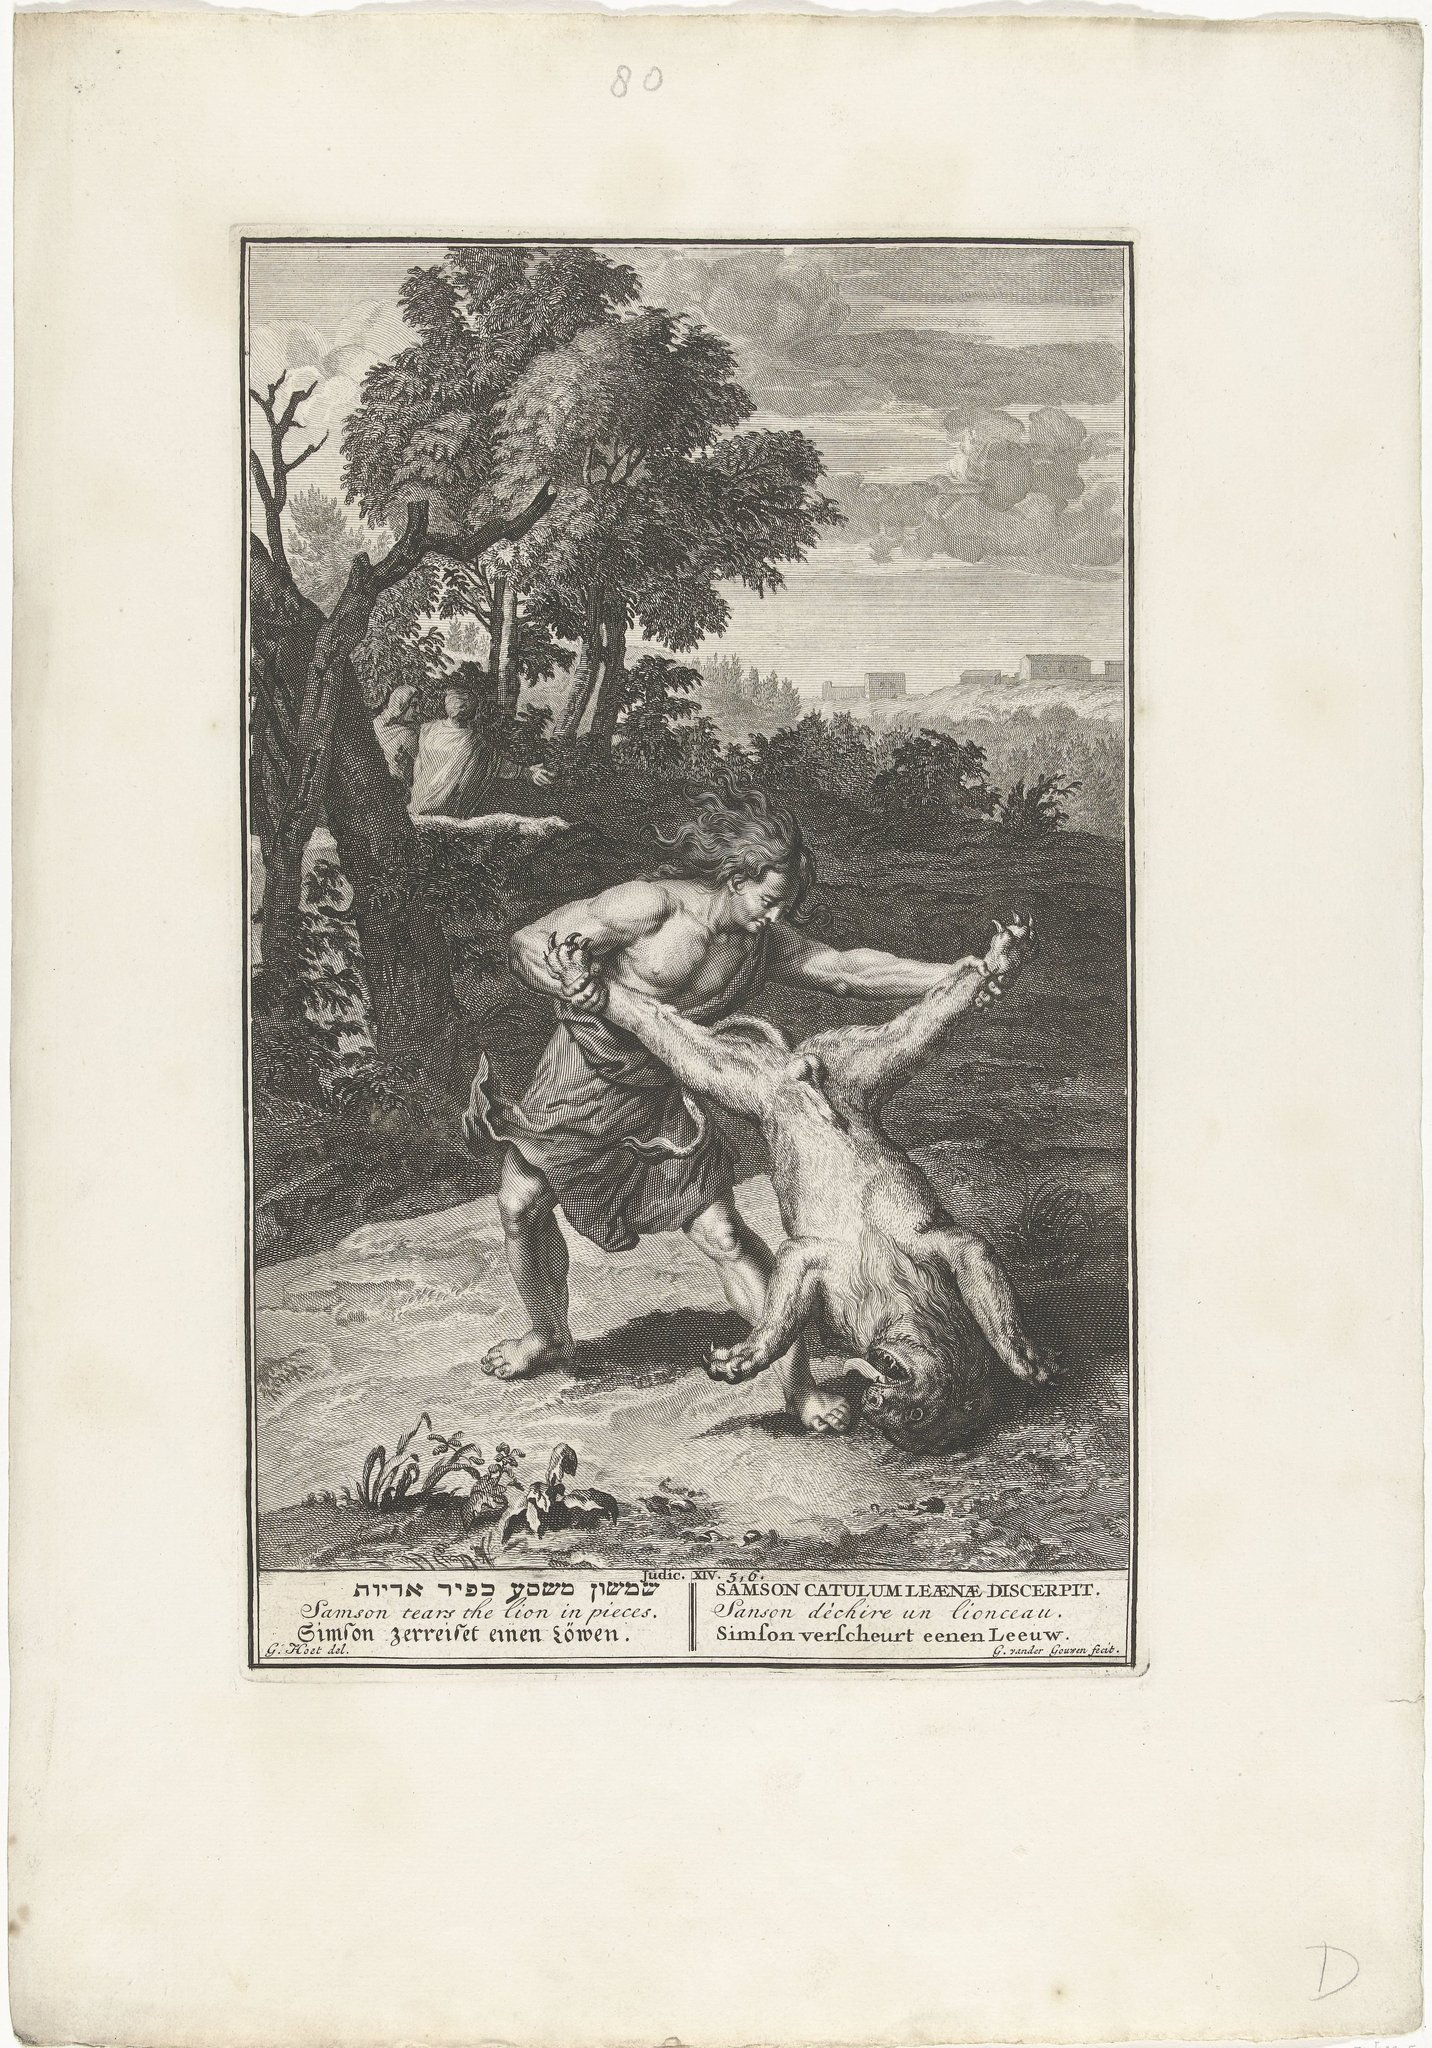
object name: book illustration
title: Simson vecht met een leeuw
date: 1728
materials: paper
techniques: engraving, etching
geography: the hague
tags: samson kills the lion with his bare hands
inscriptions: collector's mark: Lugt 2228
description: Simson vecht met een leeuw in de buurt van de wijngaarden van Timna (Ri. 14:5-6). Op de achtergrond zijn ouders, die niets opmerken. De prent heeft een Hebreeuws, Latijns, Frans, Engels, Duits en Nederlands onderschrift.